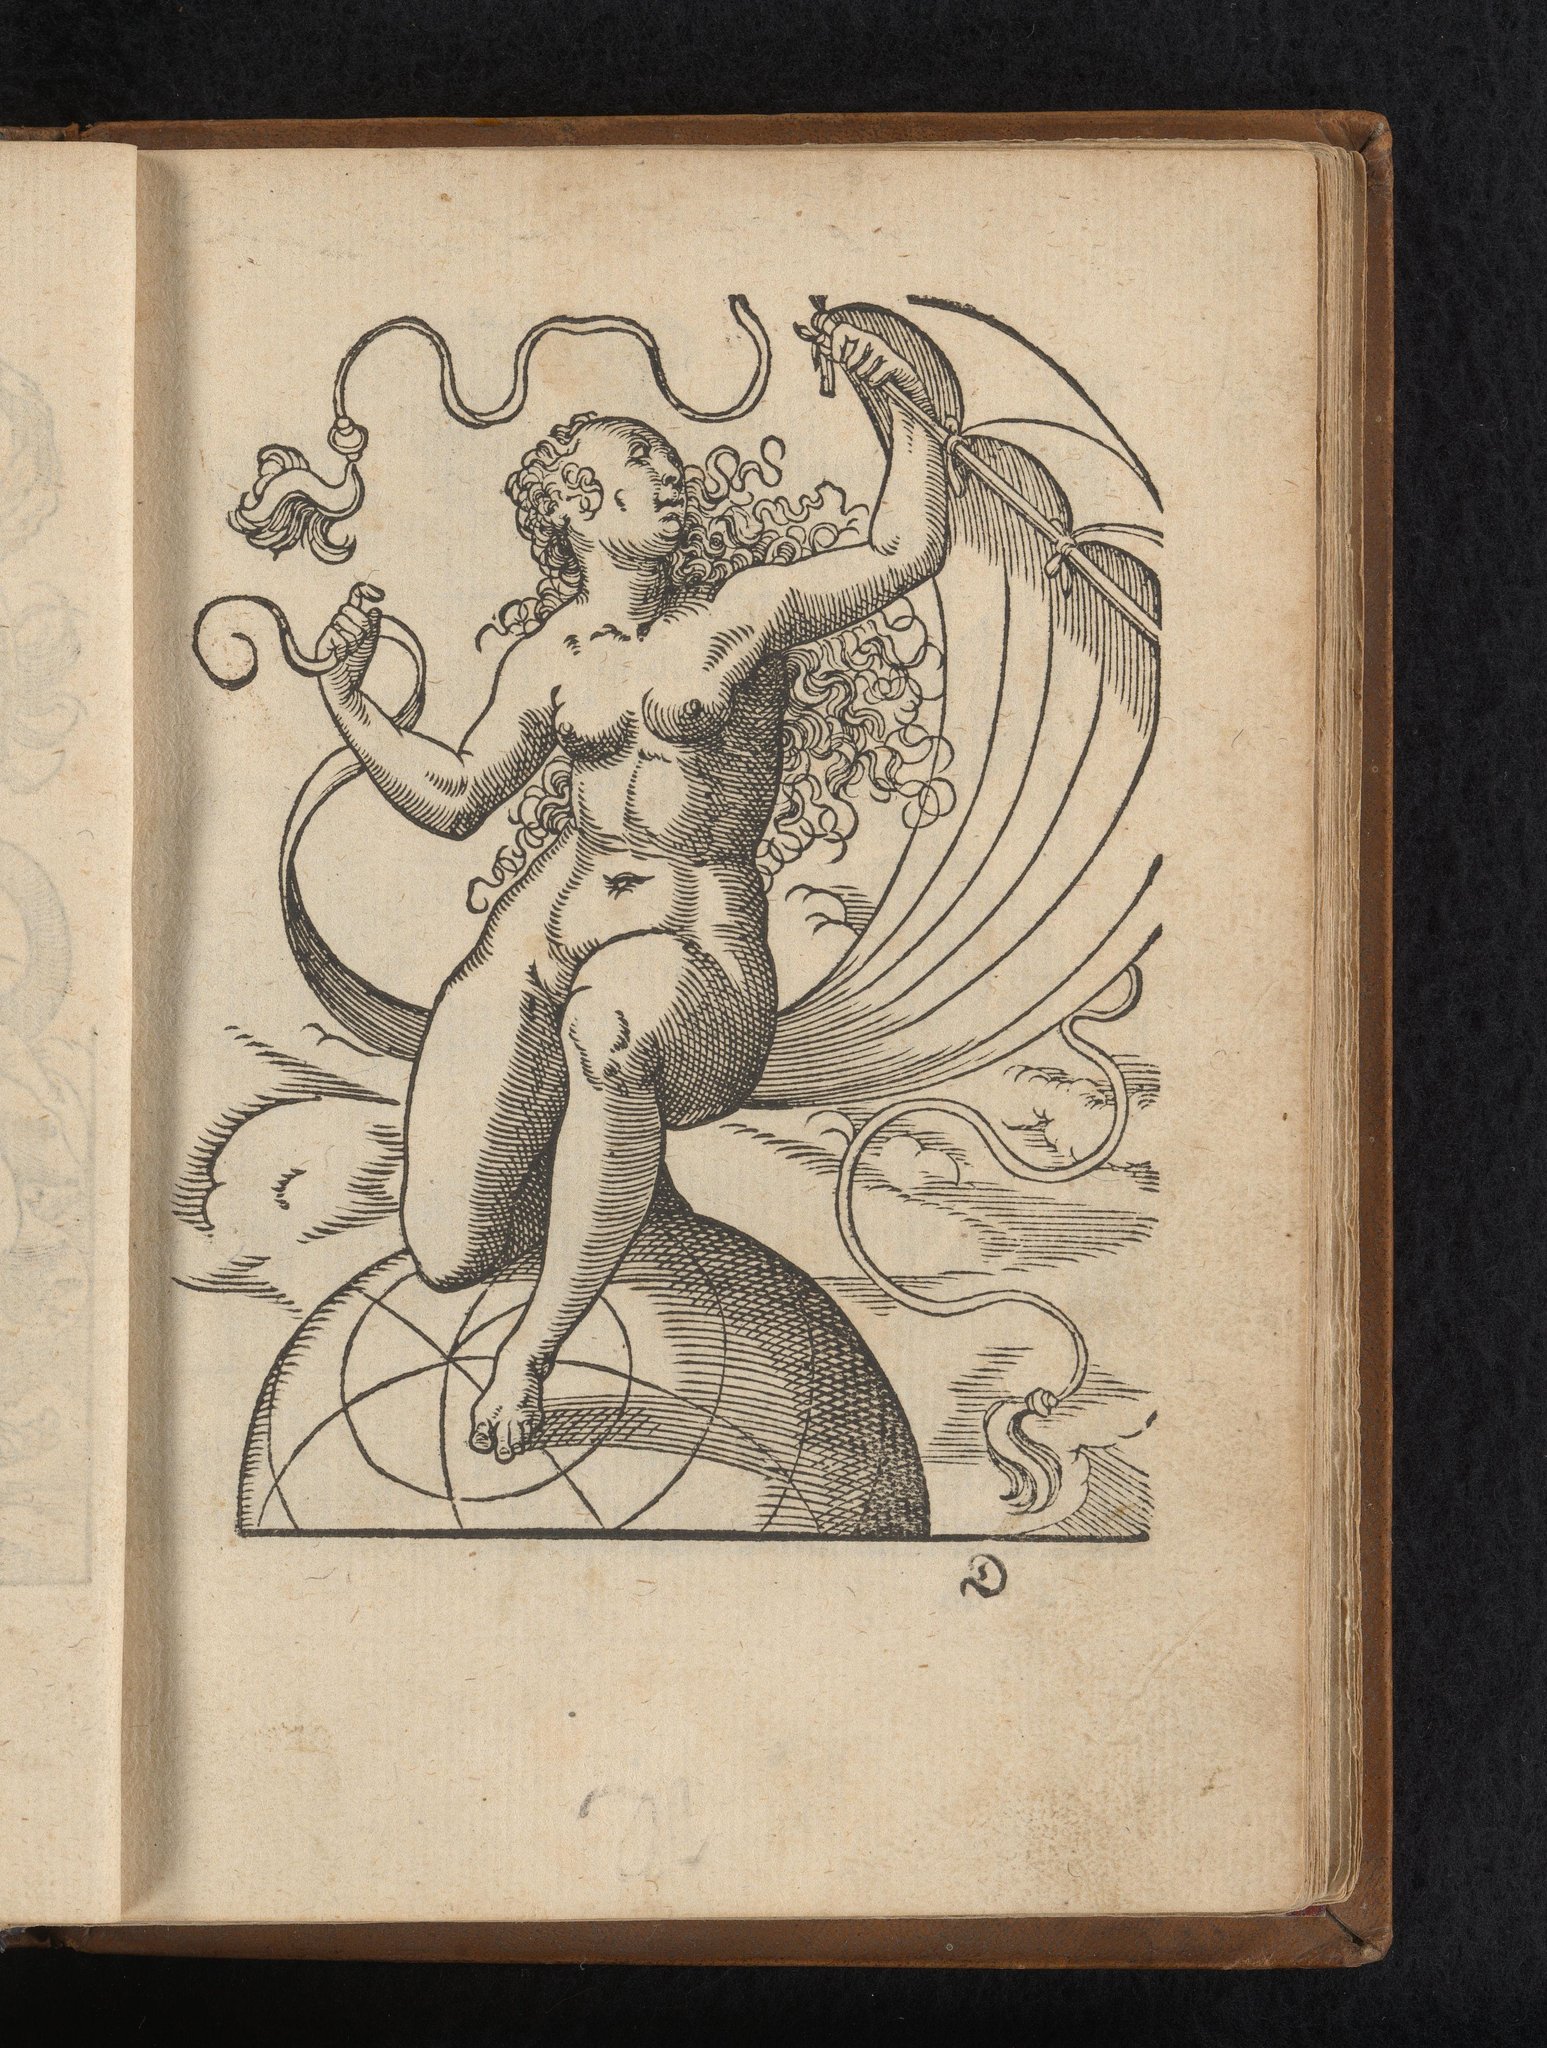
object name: print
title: Fortuna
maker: Anonymous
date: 1578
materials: paper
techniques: woodcut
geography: nuremberg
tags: luck, fortune, lot; 'fato', 'fortuna', 'fortuna aurea', 'fortuna buona', 'fortuna pacifica overo clemente', 'sorte' (ripa)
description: Fortuna, het Fortuin, een vrouw knielend op de wereldbol met een zeil of vaandel in de handen. Onderdeel van het modelboek Enchiridion artis pingendi, fingendi & sculpendi met 108 figuren bedoeld voor beginnende schilders, beeldhouwers en prentmakers.